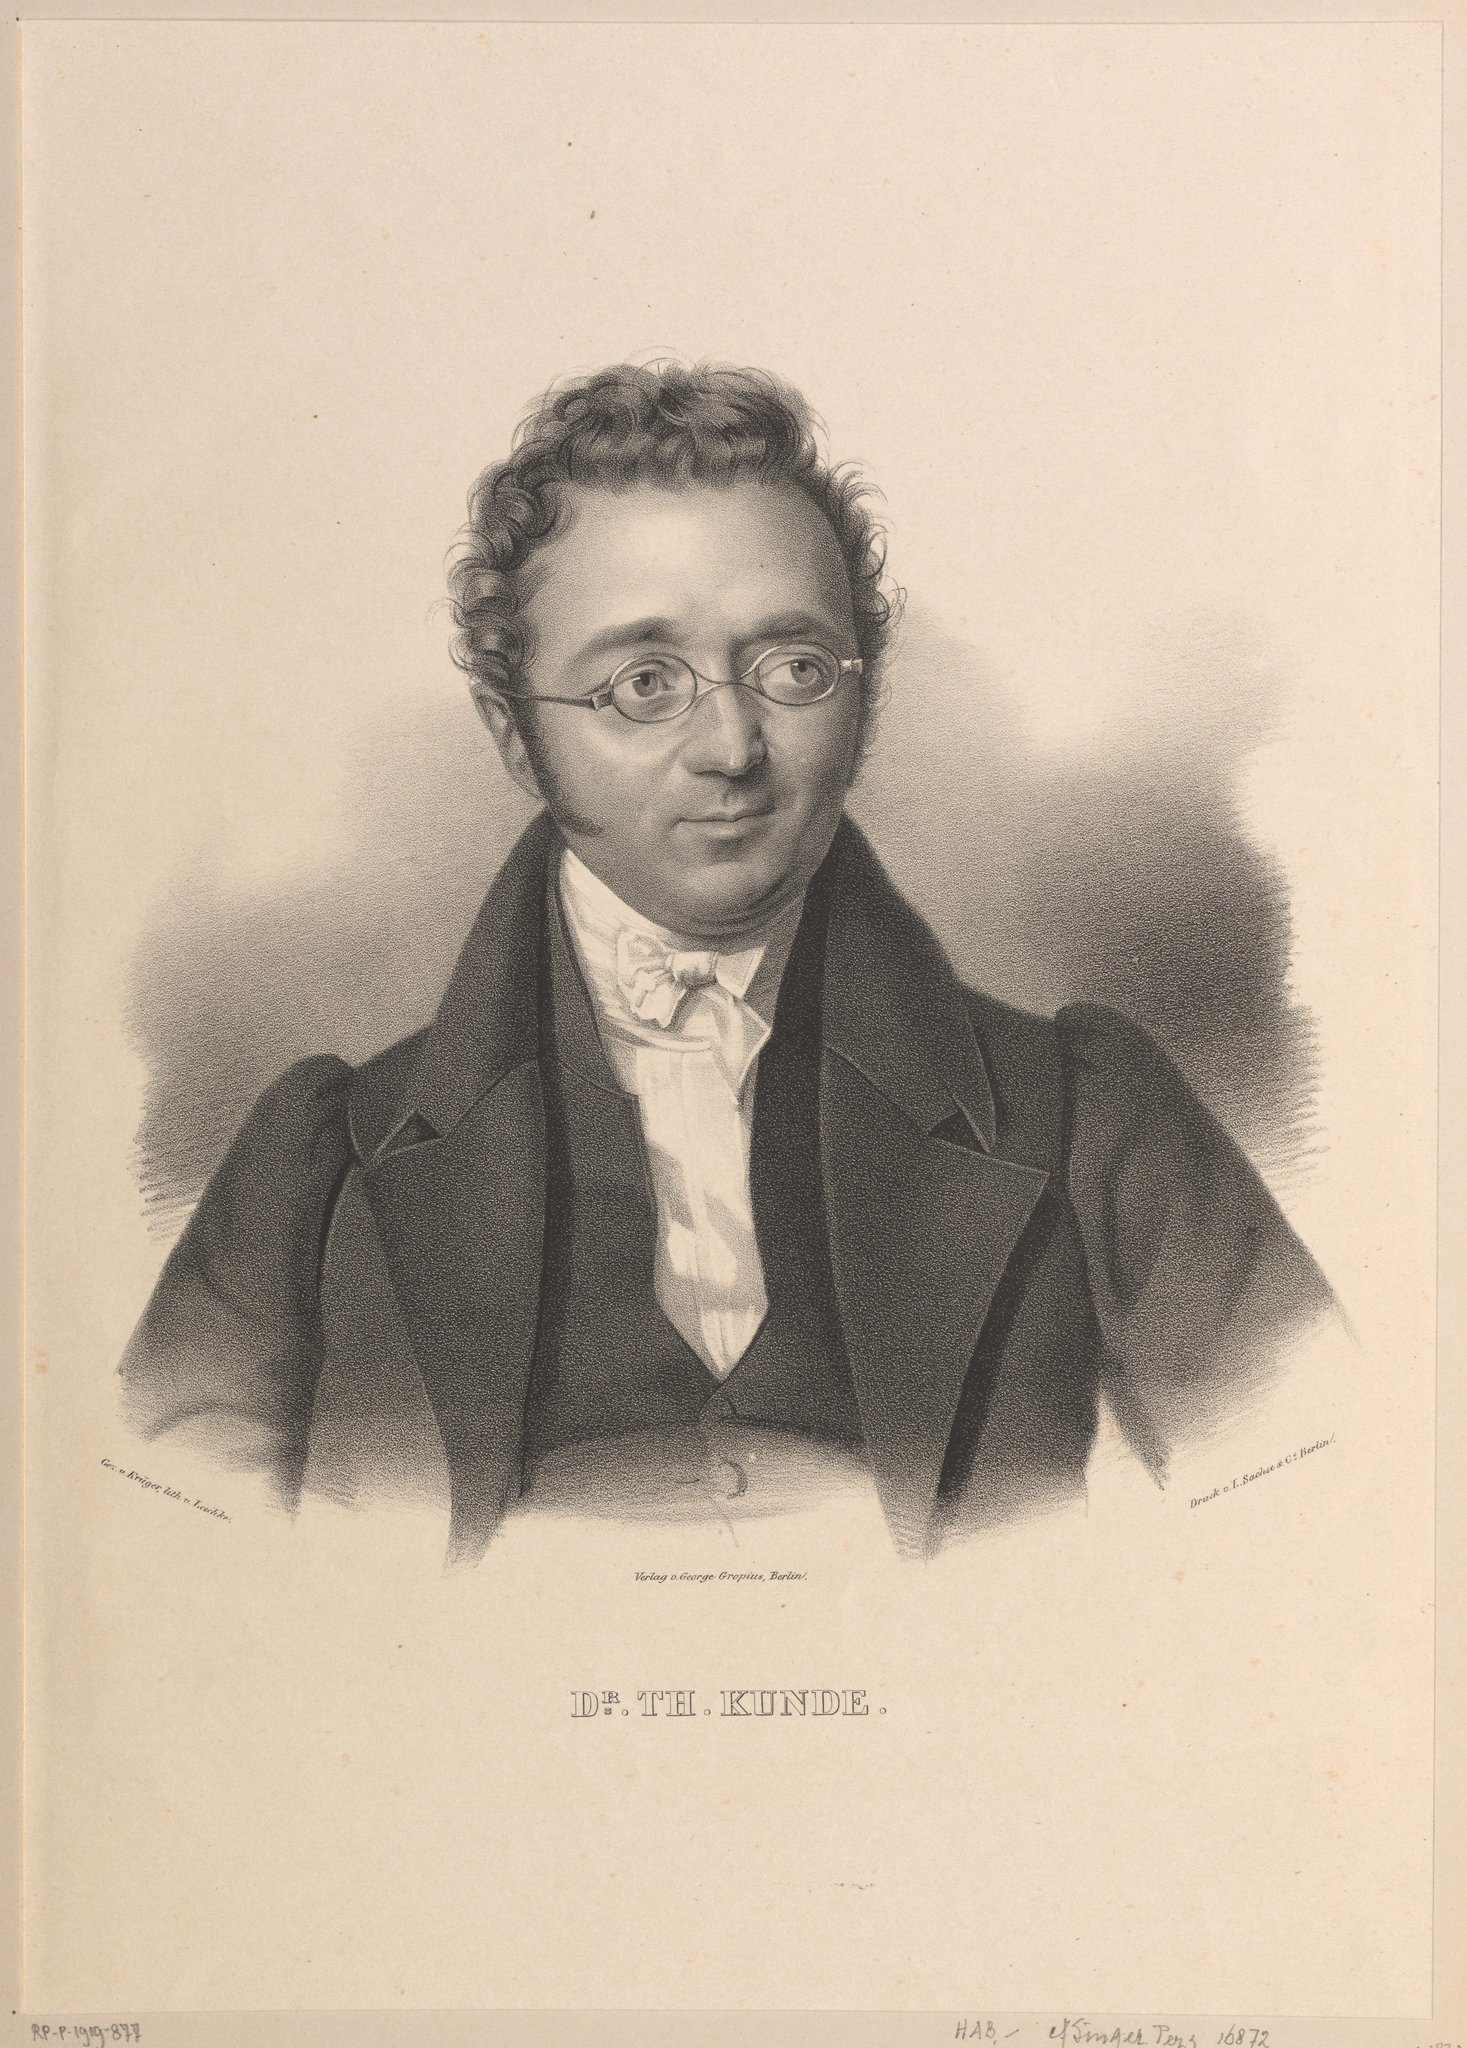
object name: print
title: Portret van Th. Kunde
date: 1832-1842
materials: paper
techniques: lithograph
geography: berlin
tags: historical persons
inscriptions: collector's mark: Lugt 2228